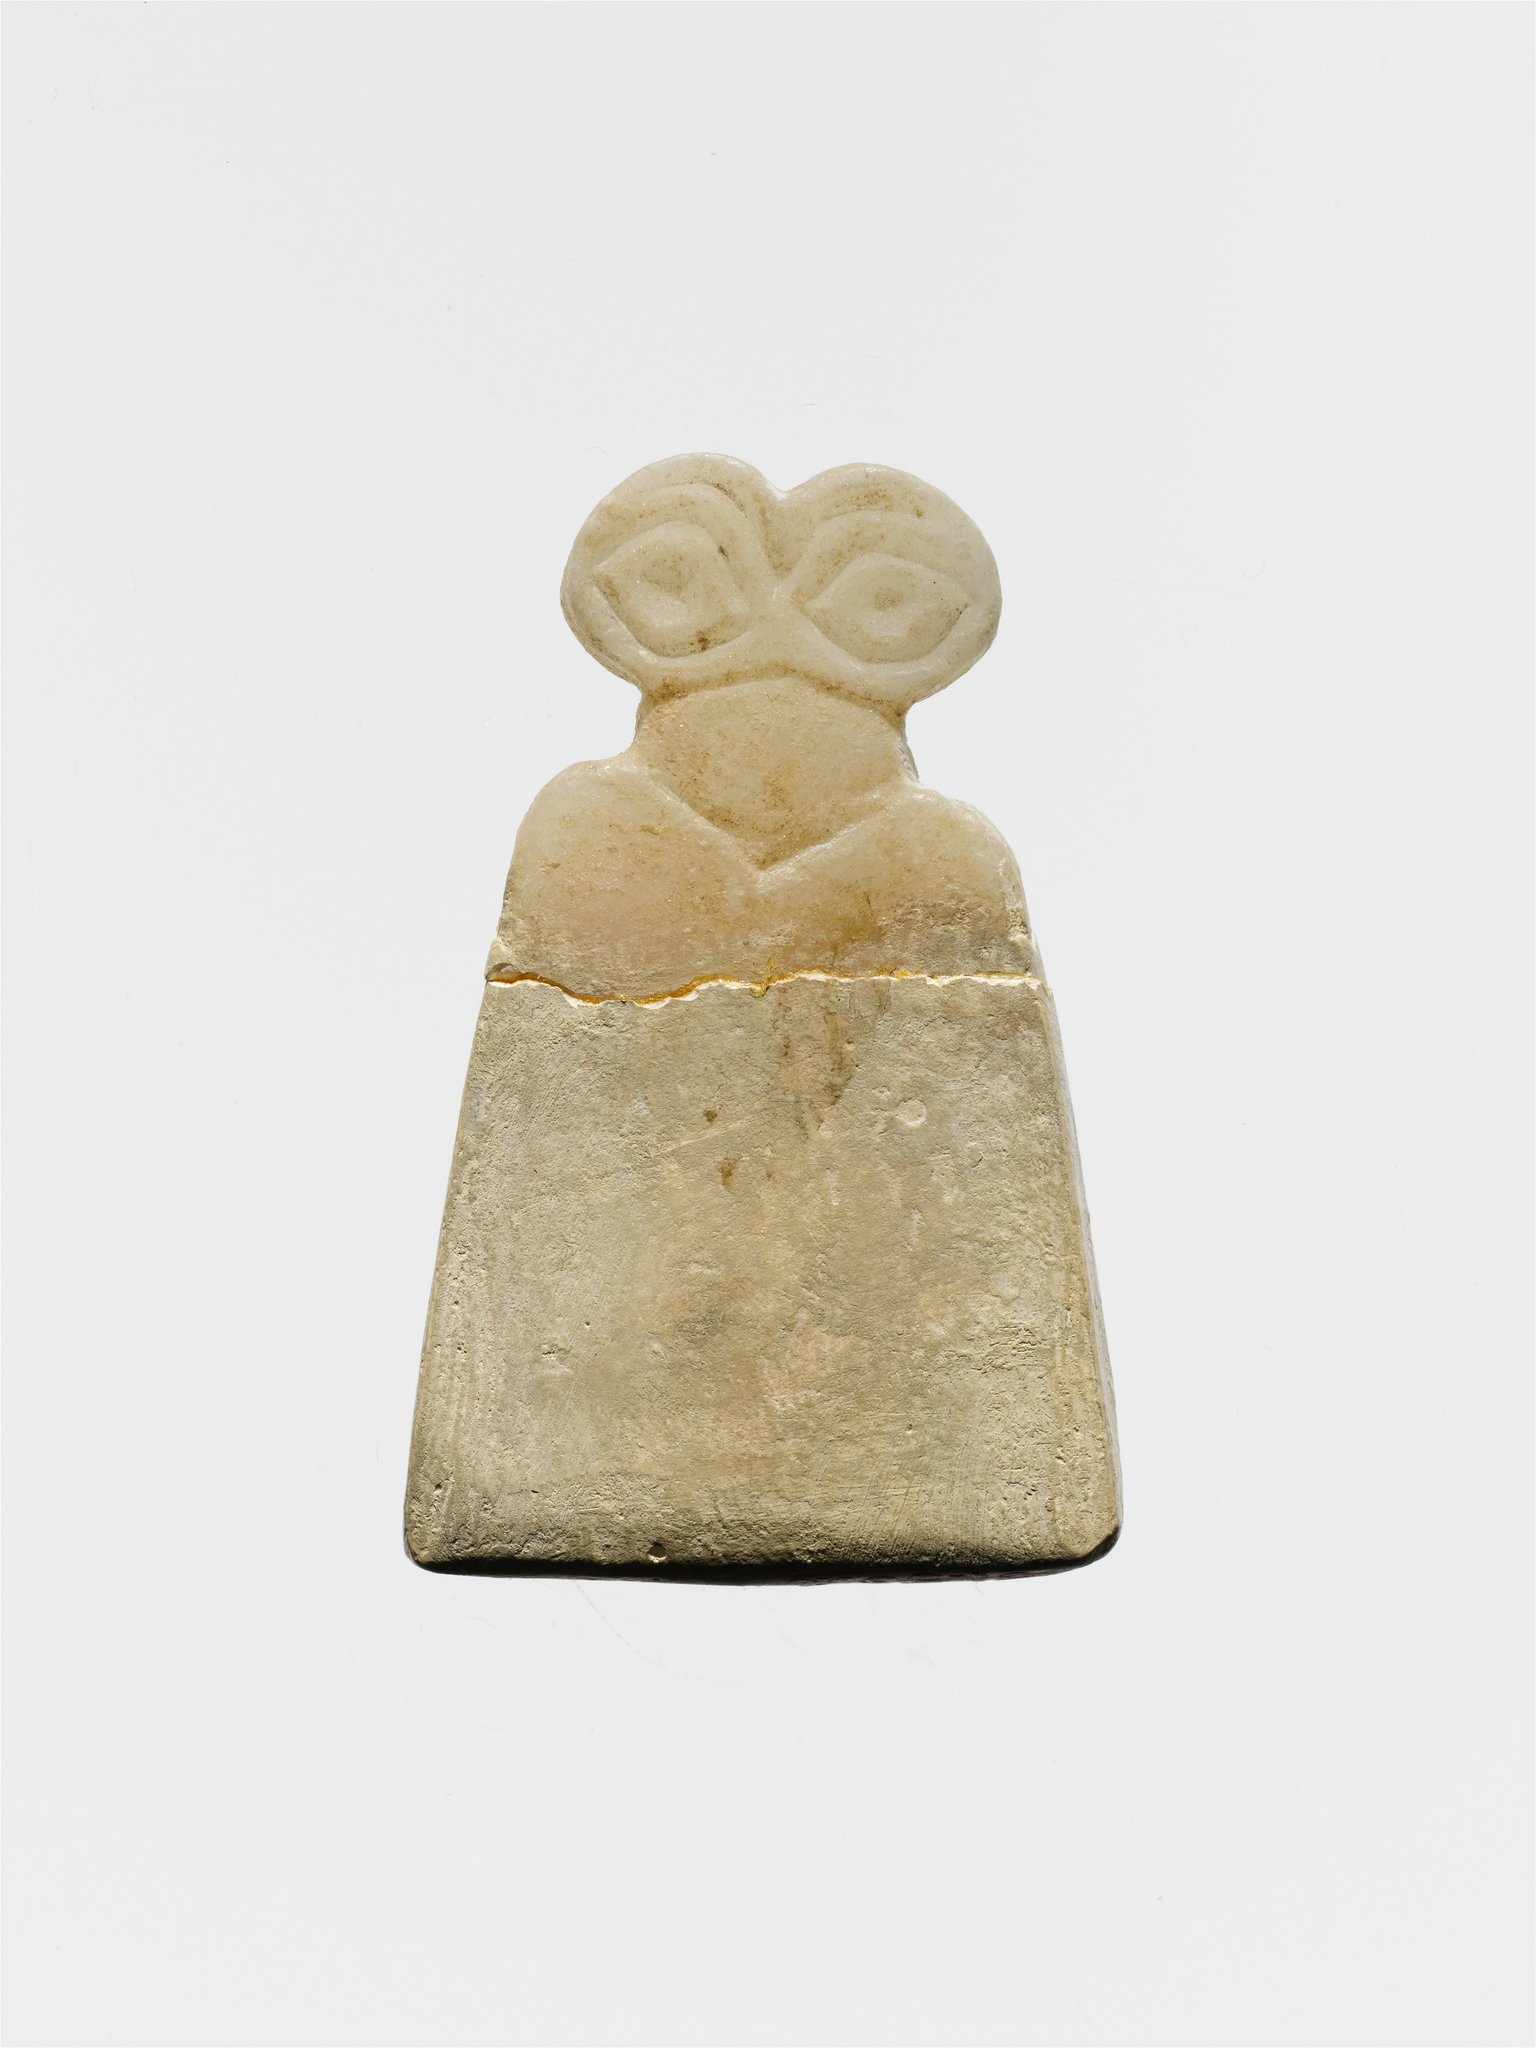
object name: sculpture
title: Eye idol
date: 3700-3500 BCE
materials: alabaster, gypsum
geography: syria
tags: eyes